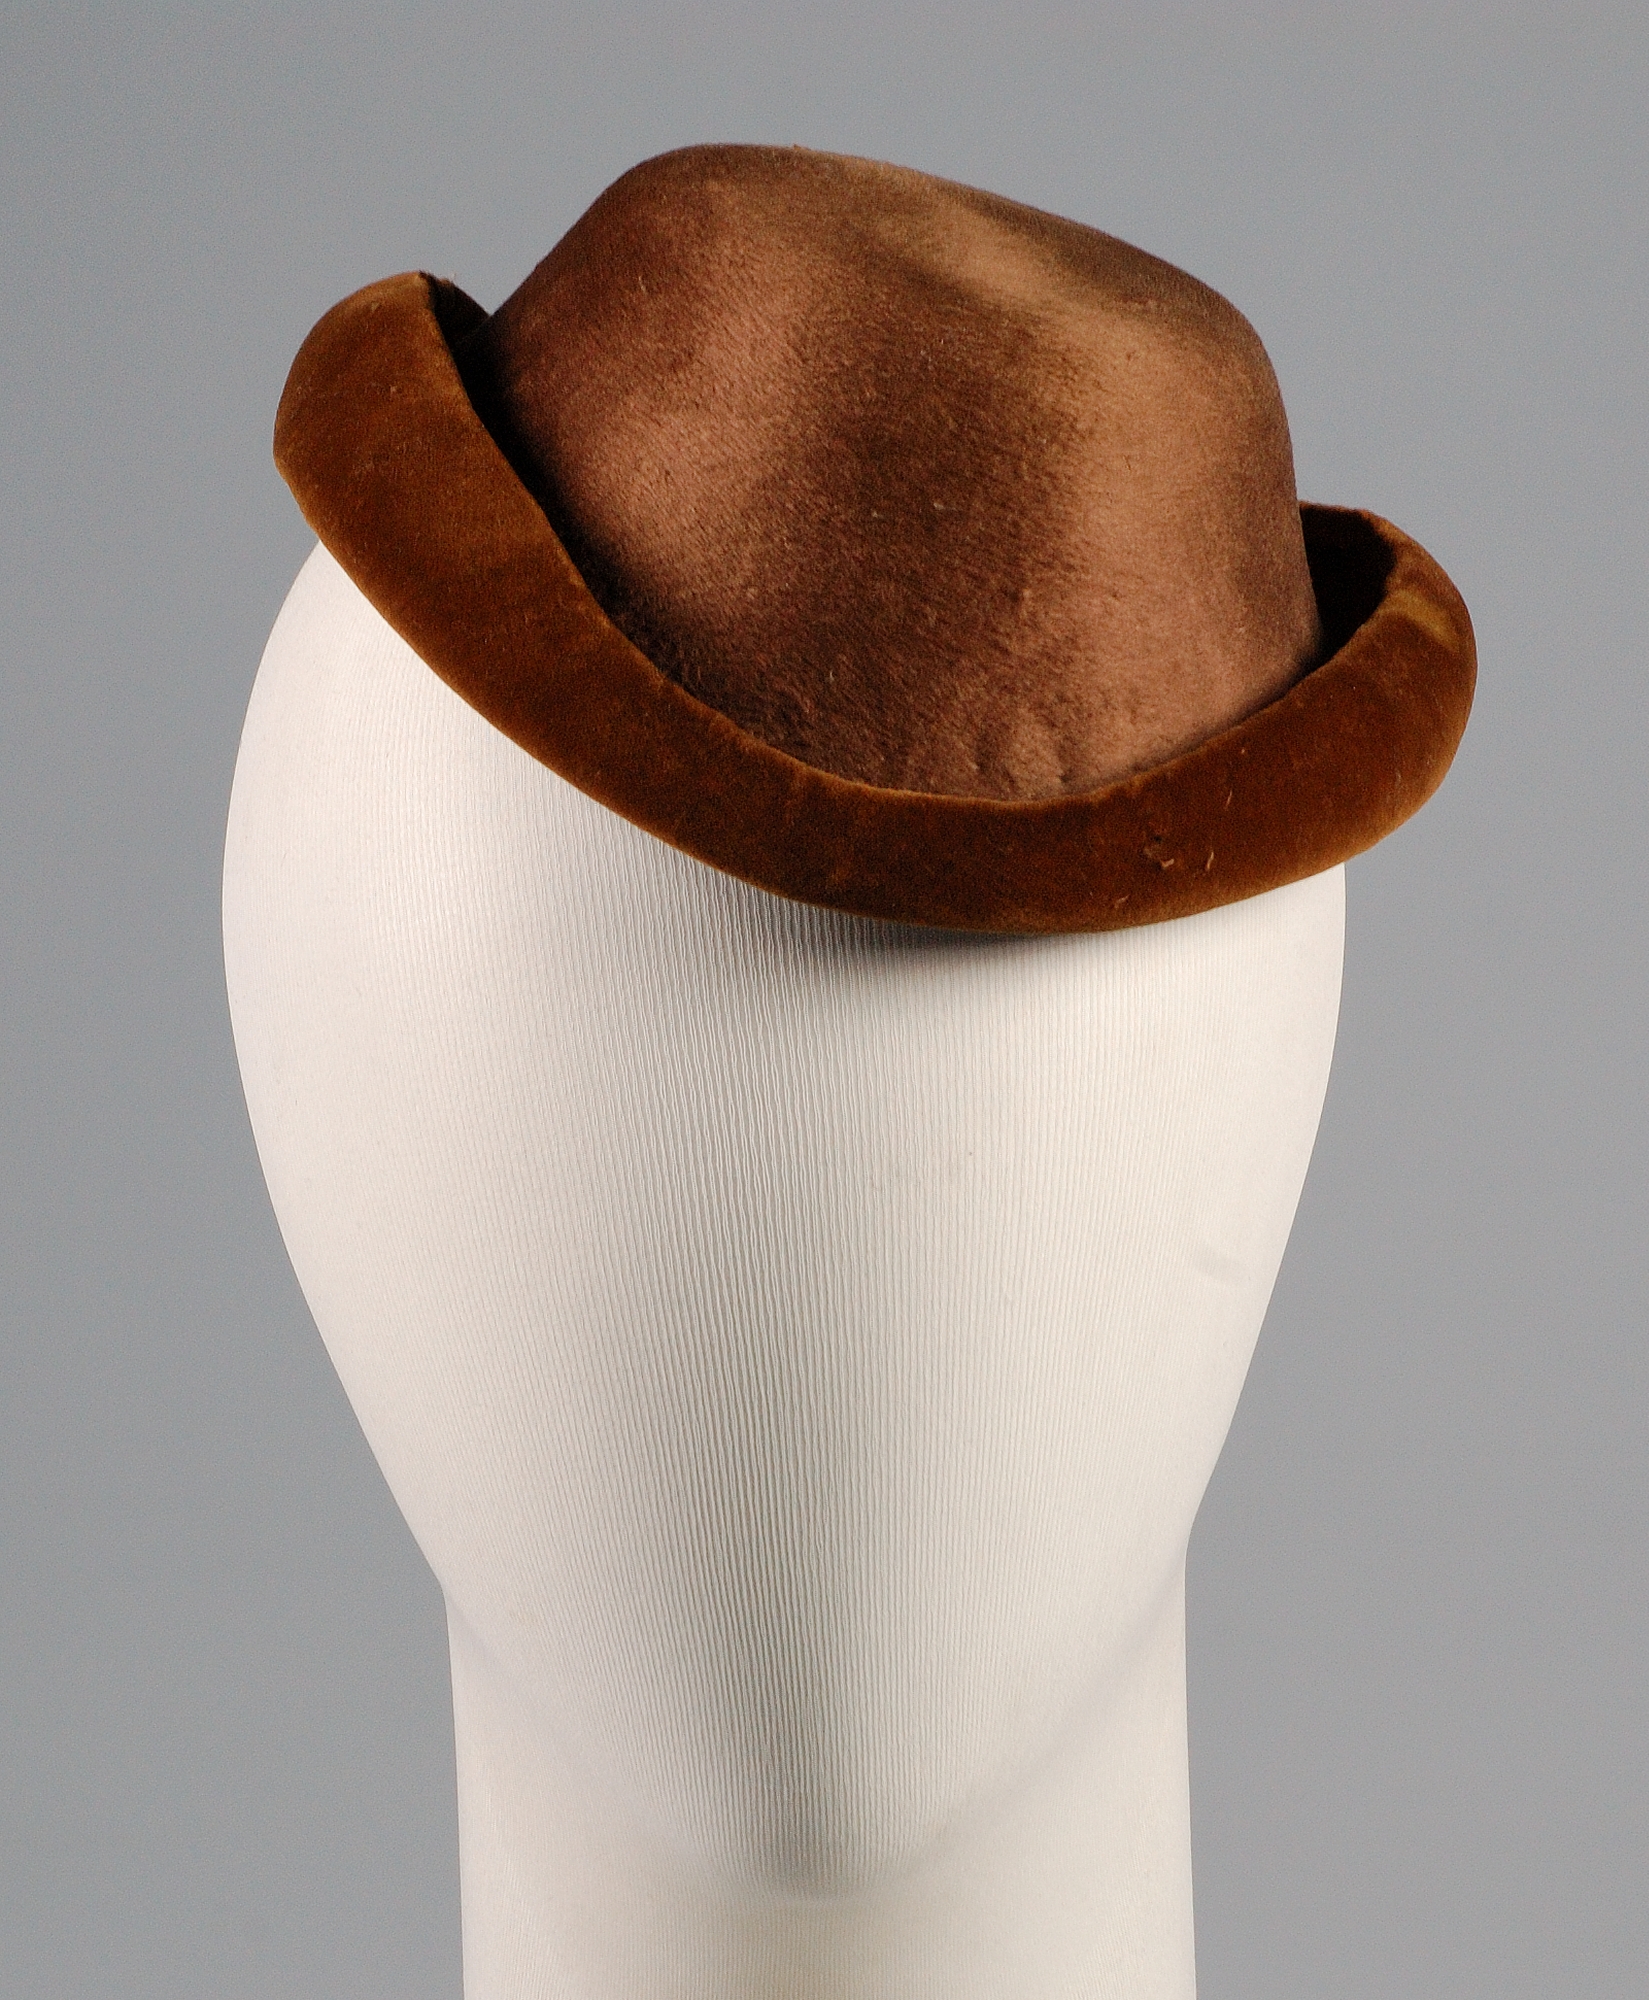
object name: hat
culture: american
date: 1869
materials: cotton, fur